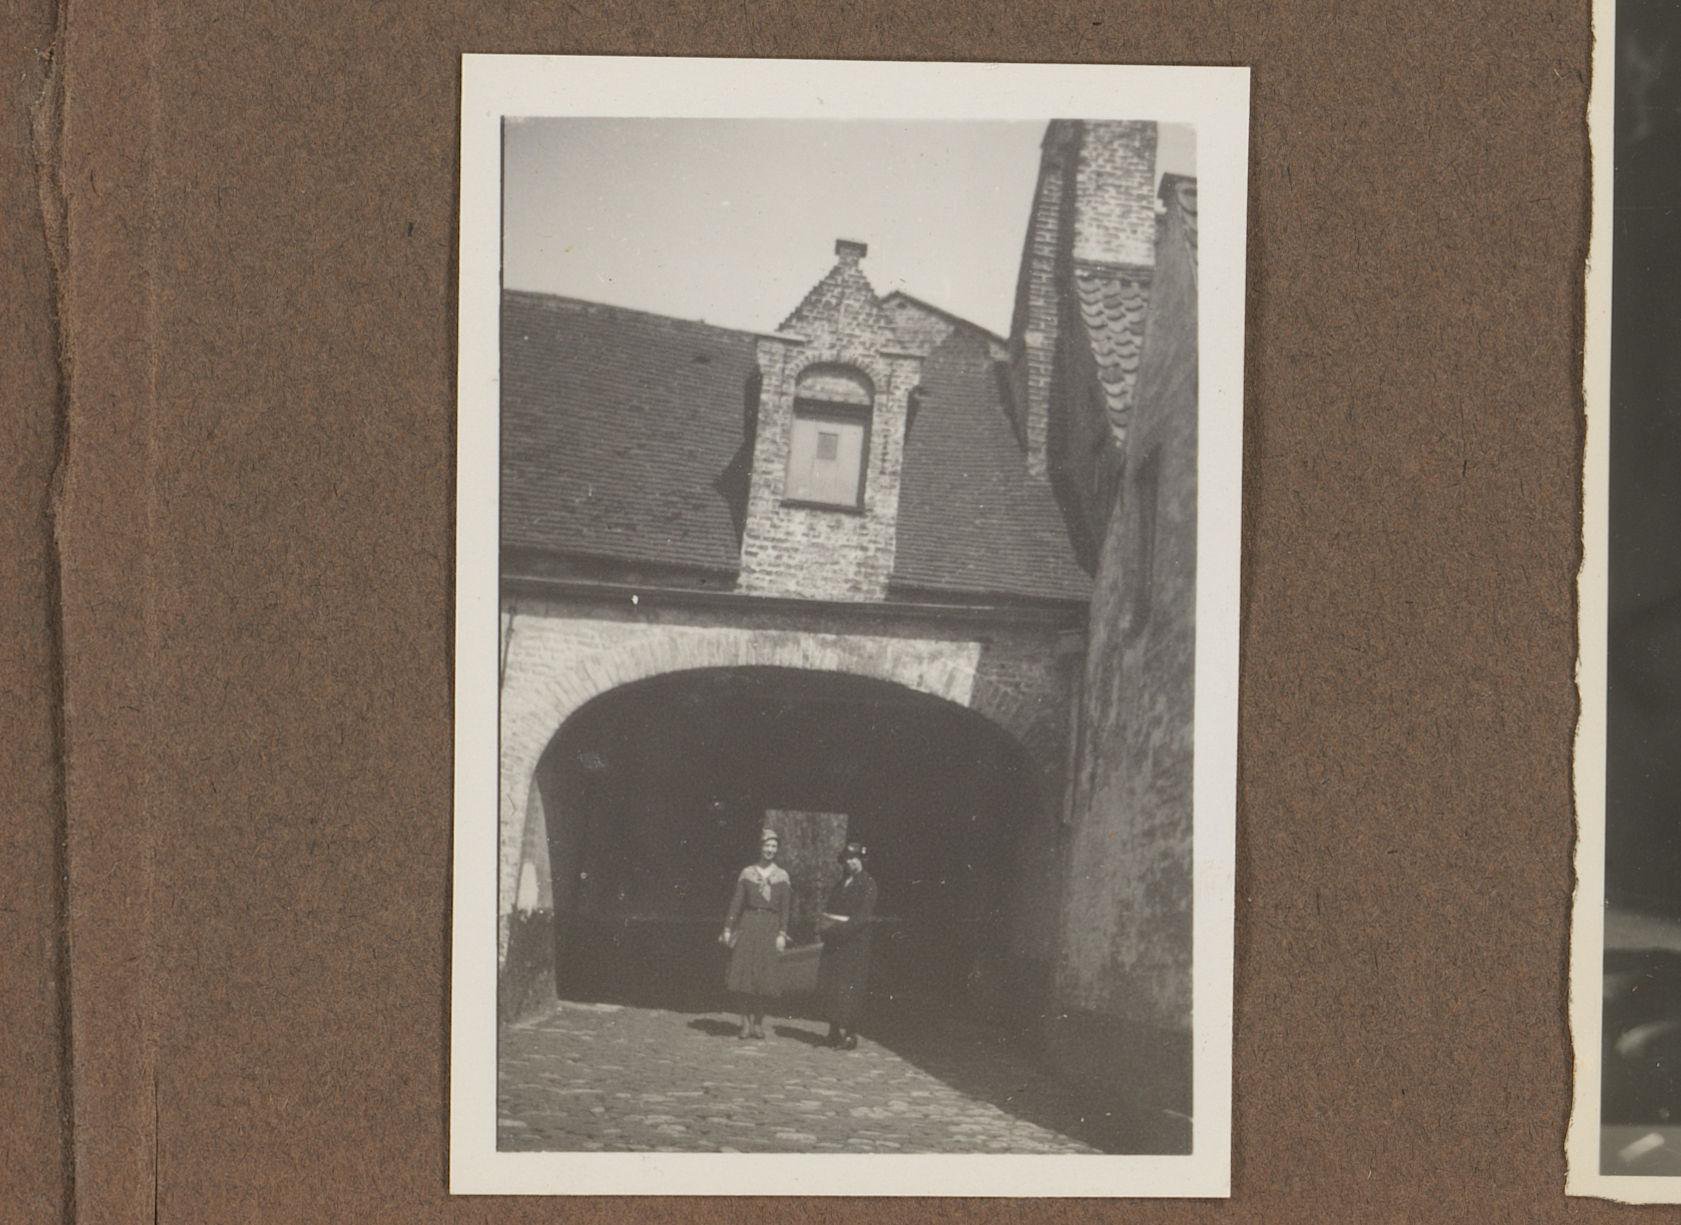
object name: photograph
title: Twee vrouwen bij een poort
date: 1900-1915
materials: photographic support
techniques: photography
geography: amsterdam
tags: netherlands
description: Foto op bruin albumblad 53 van familiealbum van Alphons Diepenbrock.